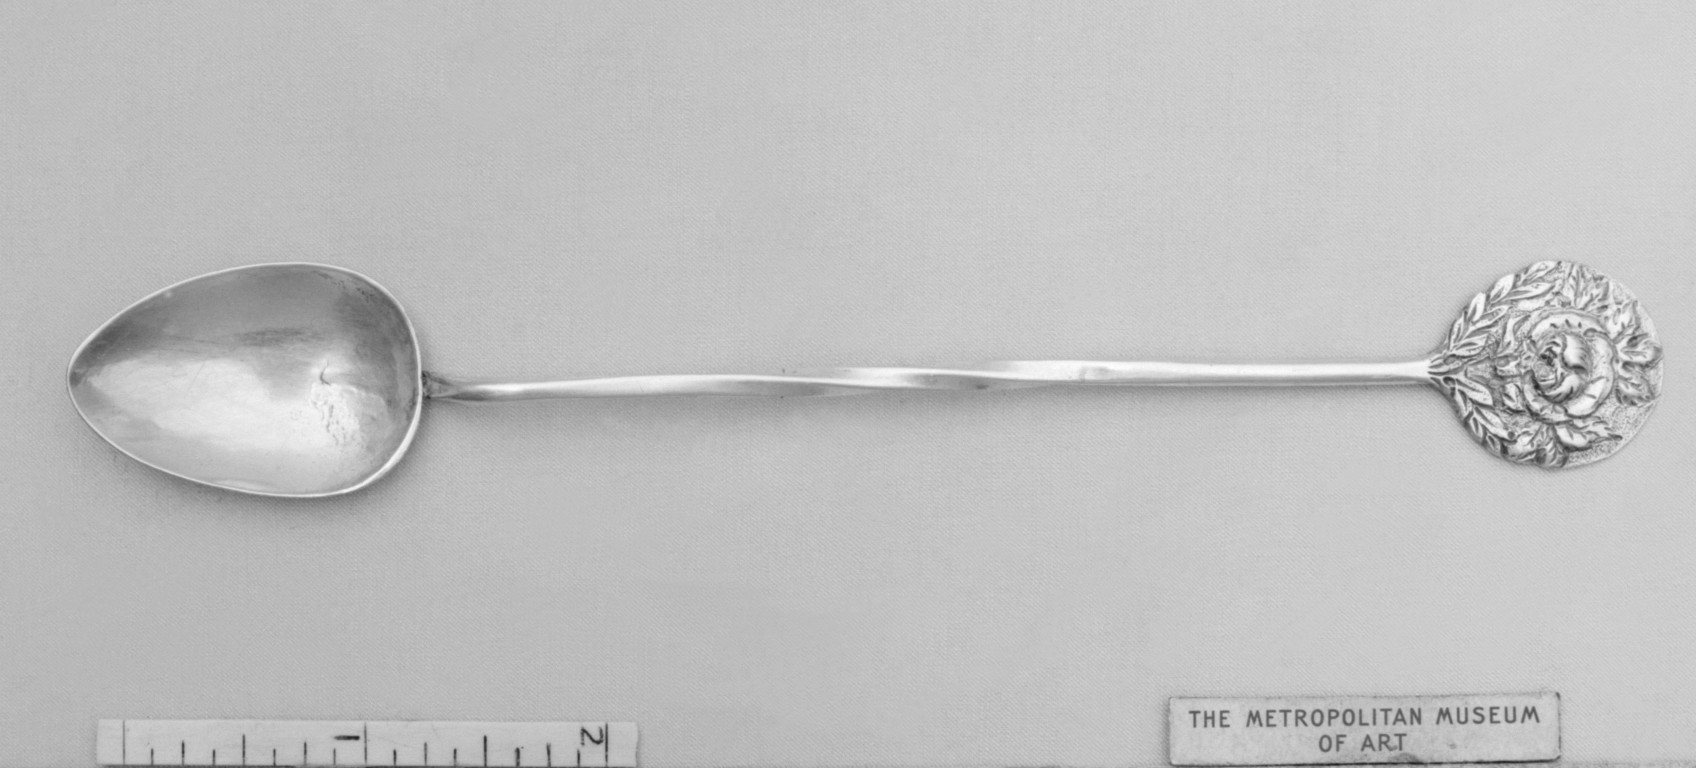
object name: spoon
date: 1701-1800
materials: gilt, silver